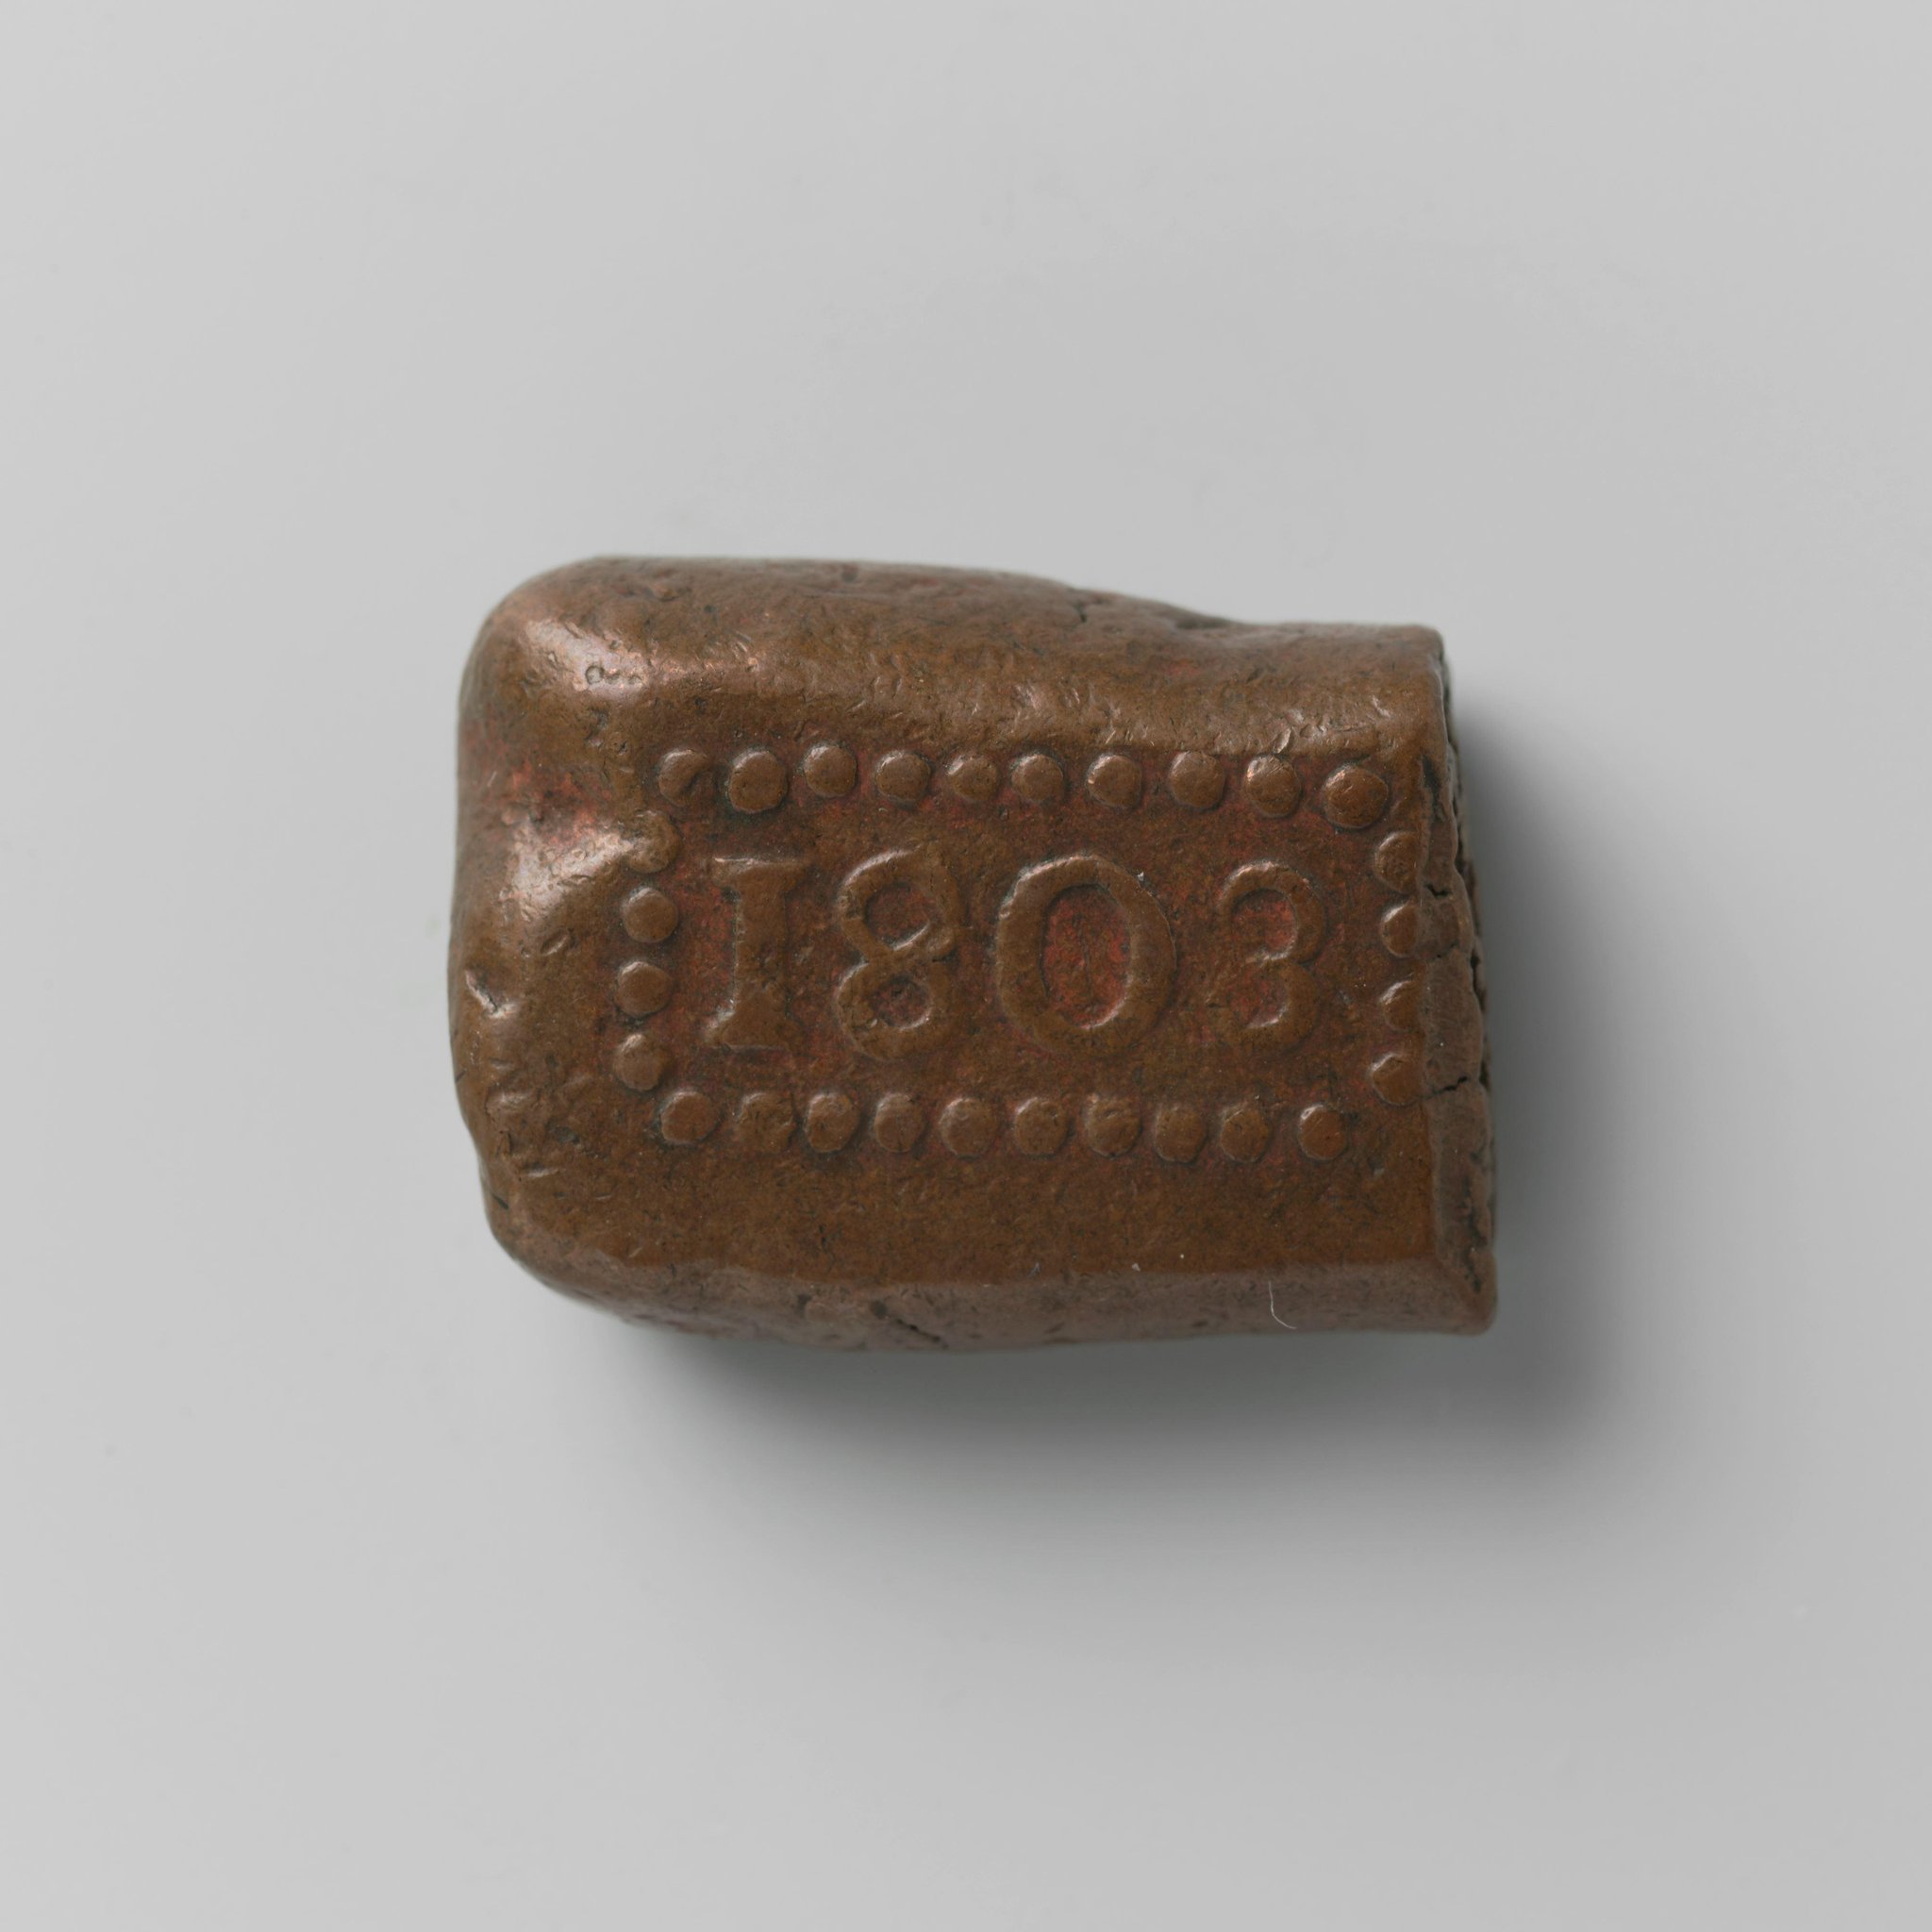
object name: coin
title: Bonk van 1 stuiver van Nederlands Indië,1803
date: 1803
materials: copper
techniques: striking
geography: batavia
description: Koperen rechthoekige munt. Voorzijde: binnen een rechthoekige lijst van parels waarde-aanduiding 1 S. Keerzijde: binnen een rechthoekige lijst van parels jaartal.